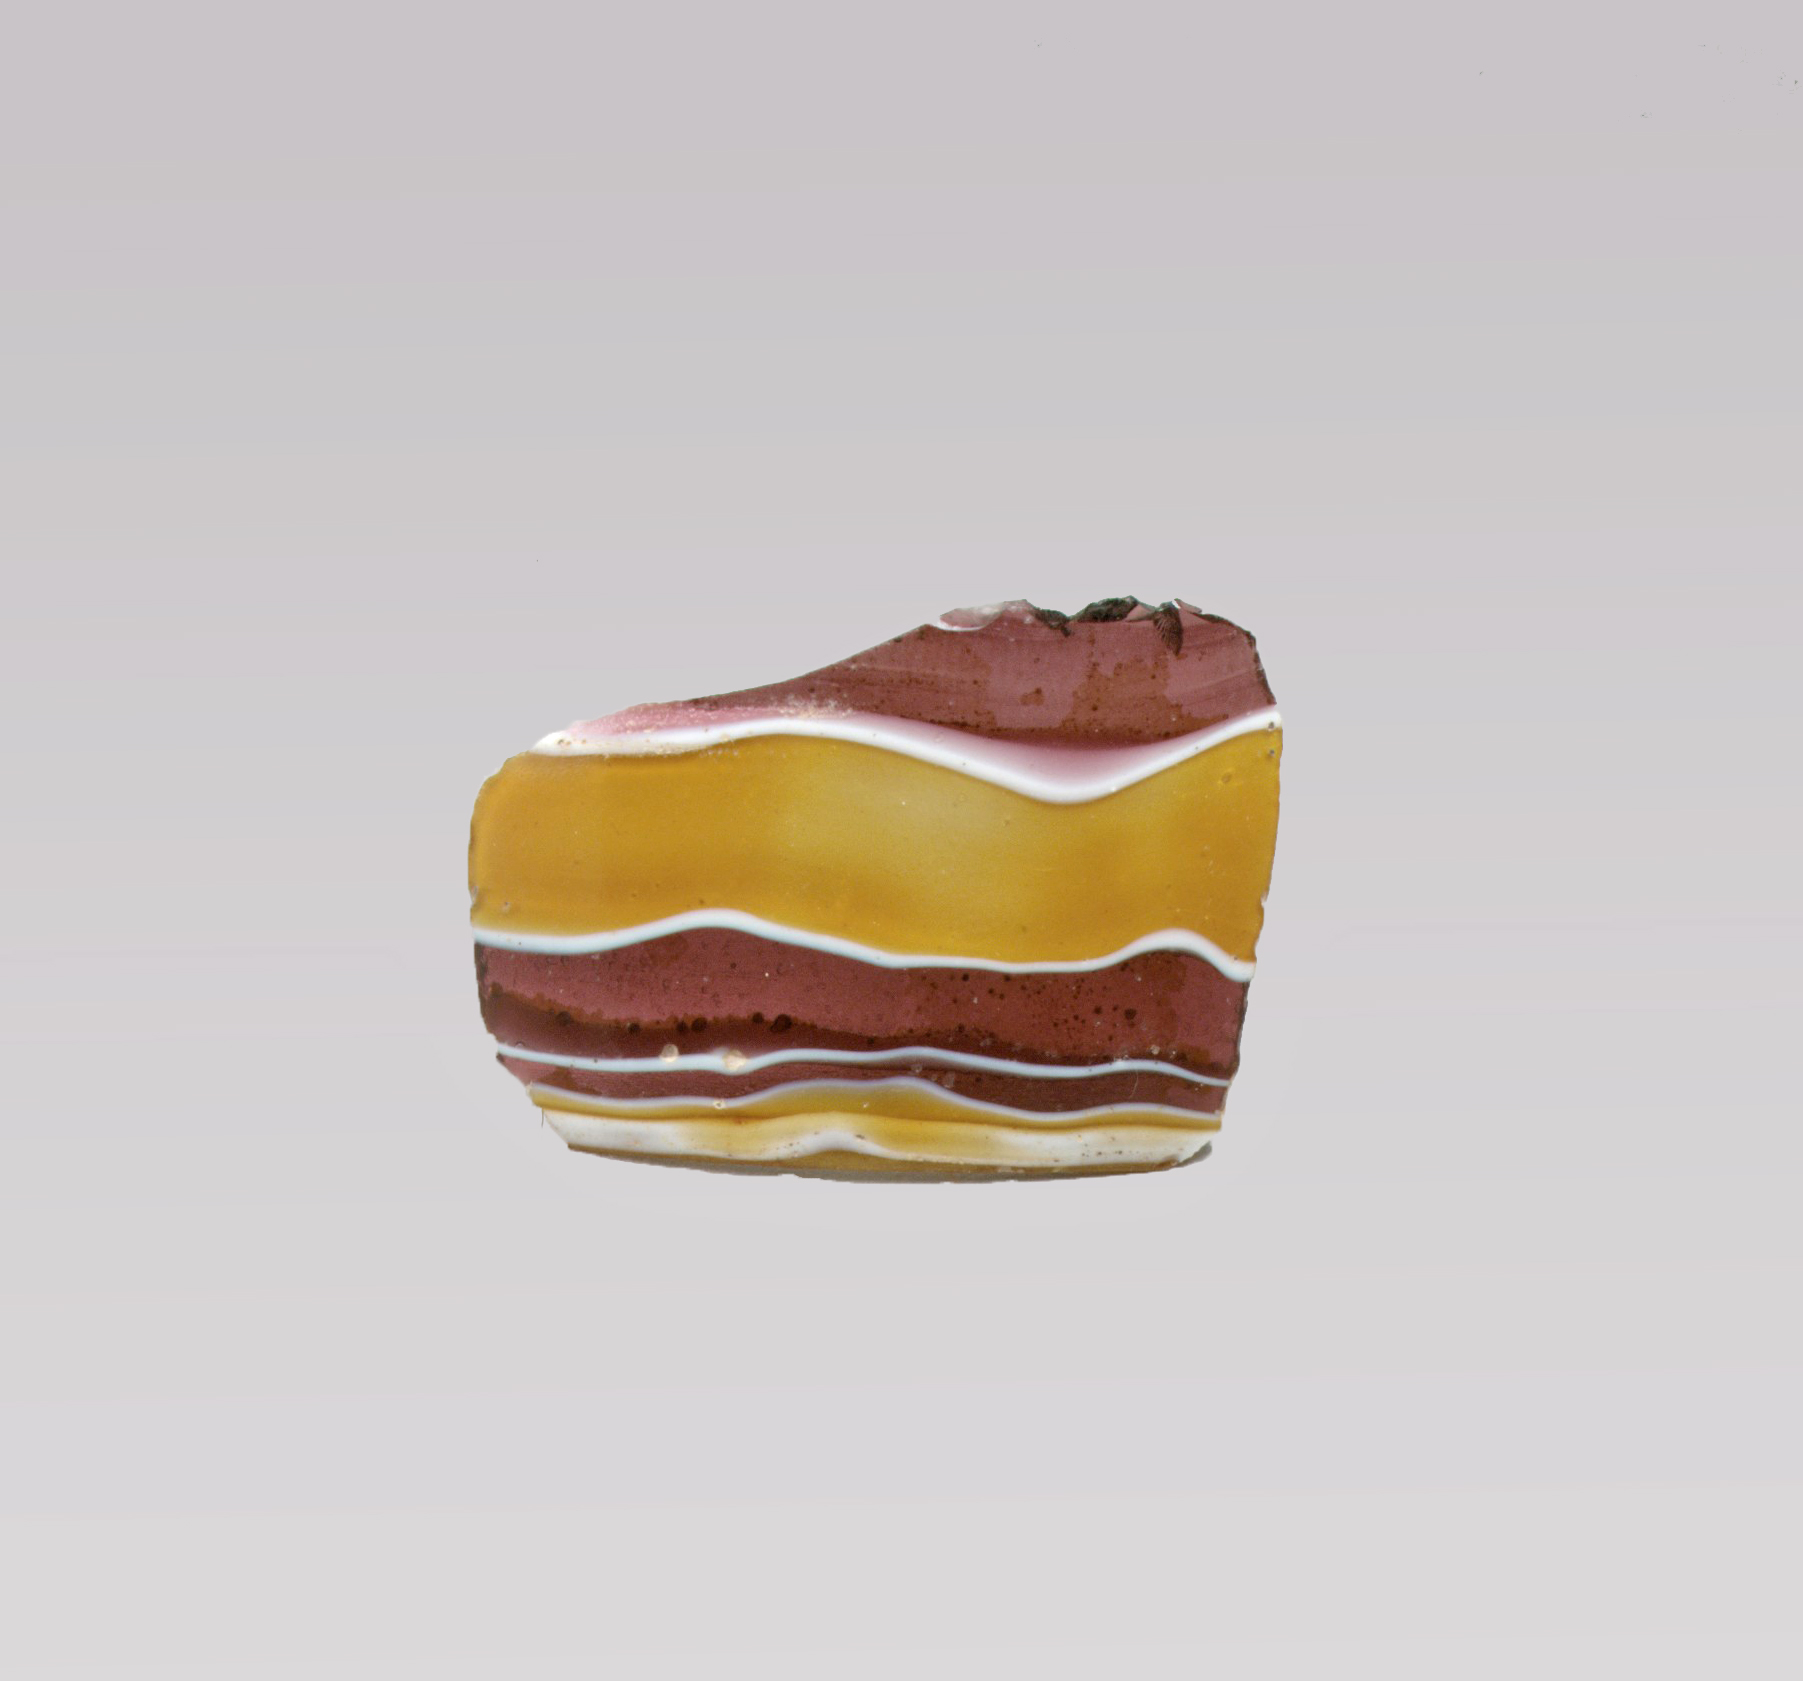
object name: fragment, mosaic bowl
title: Glass mosaic bowl fragment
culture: roman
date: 34 BCE-33 CE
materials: glass